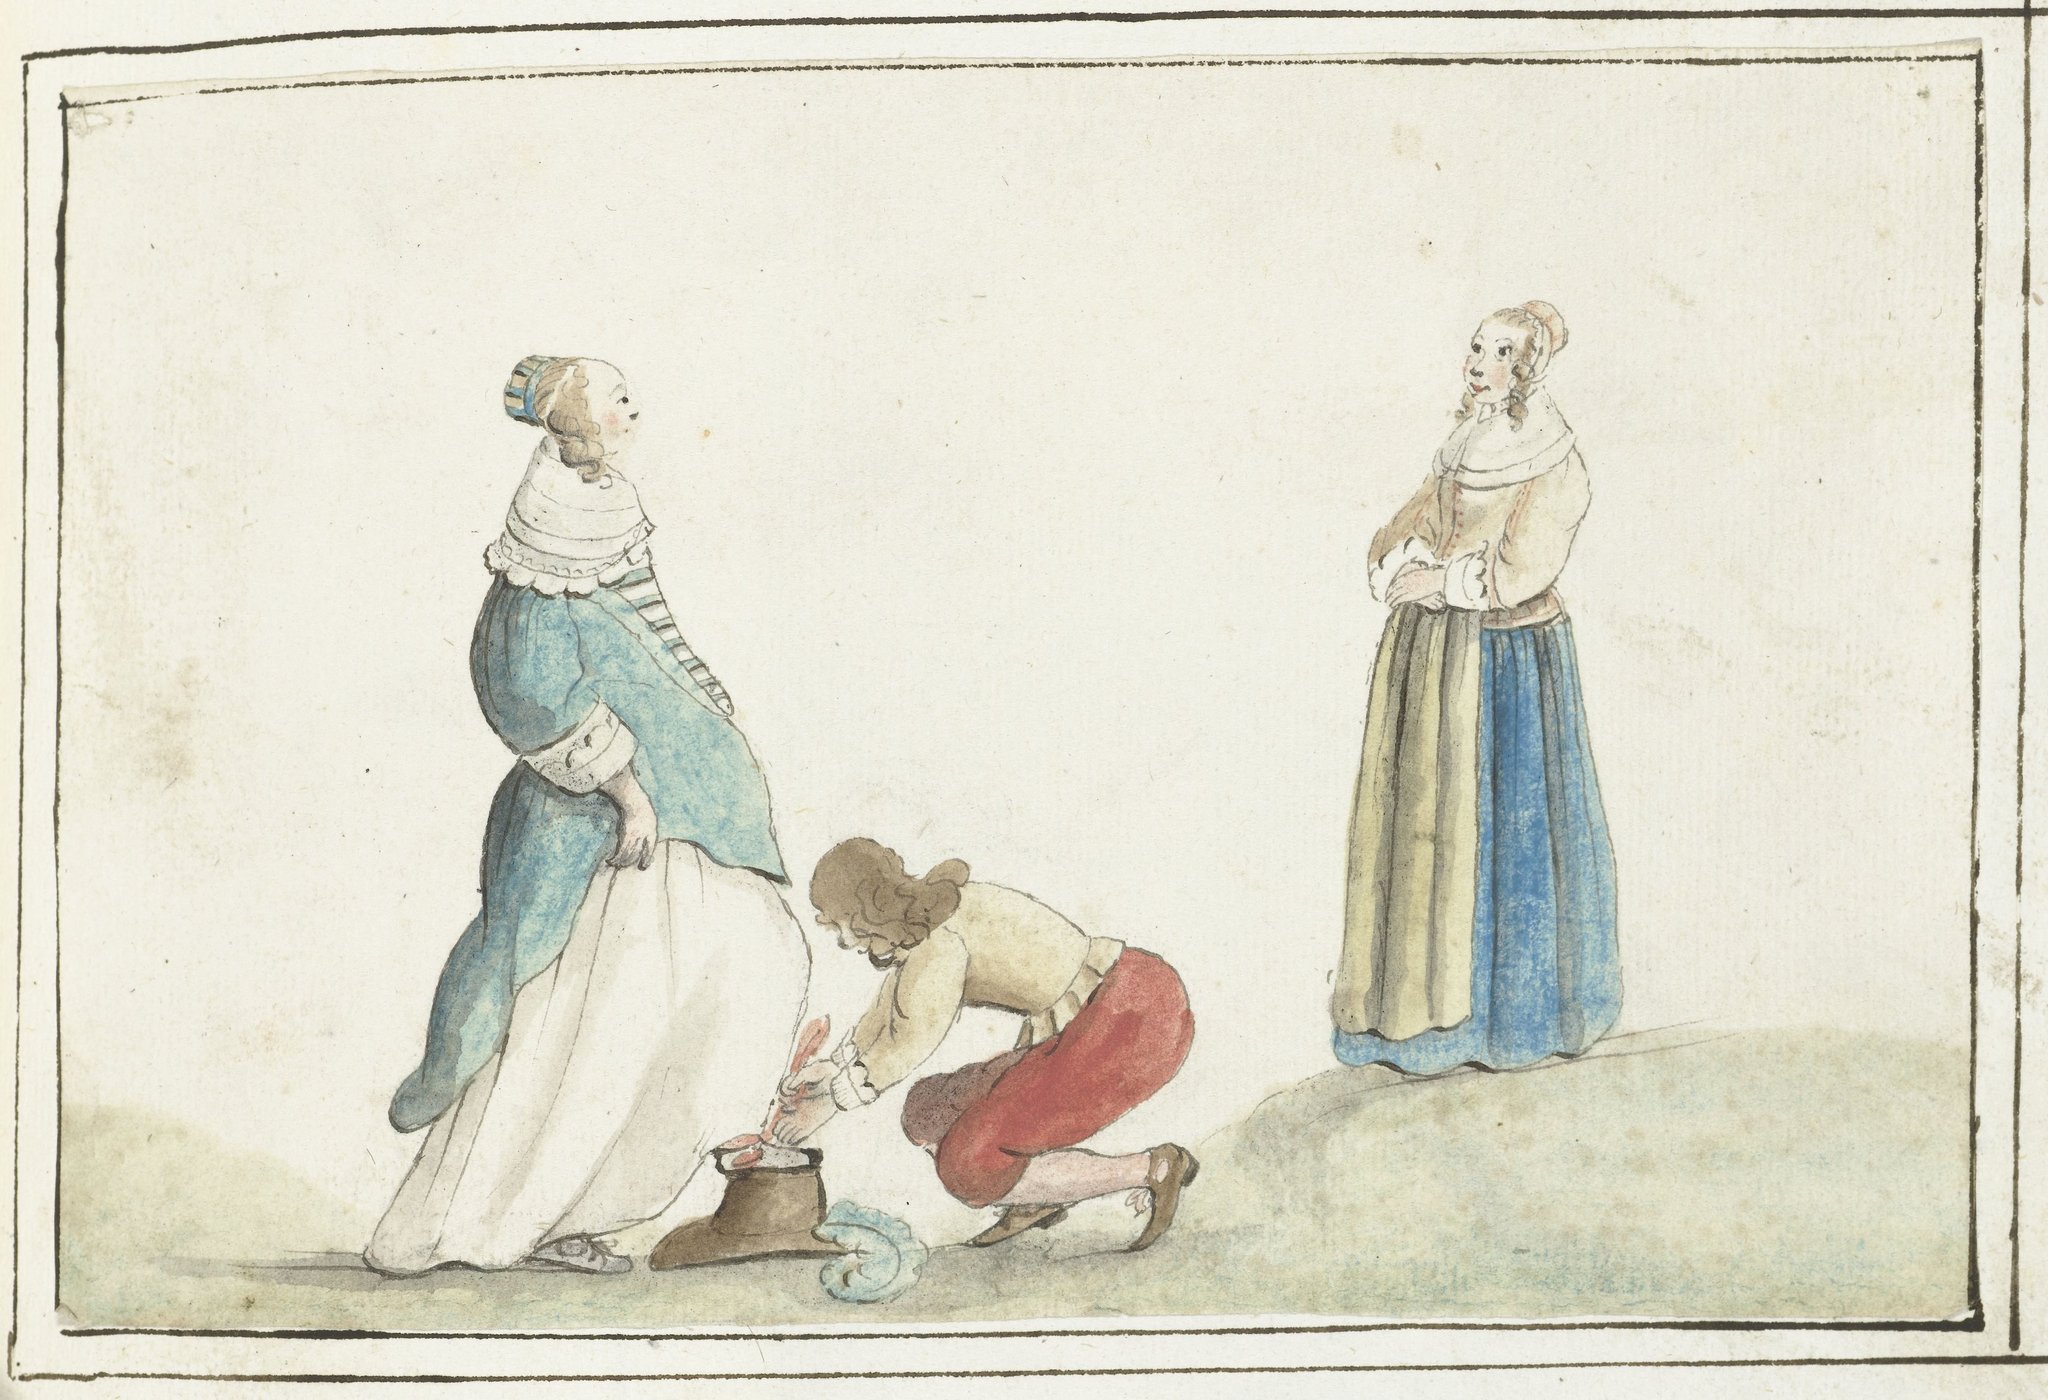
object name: drawing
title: Heer strikt de schoen van een dame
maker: gesina ter borch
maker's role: draughtsman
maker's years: 1633-1690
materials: ink, paper, watercolor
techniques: brush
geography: zwolle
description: Een heer strikt de schoen van een dame; een andere dame staat ernaast.